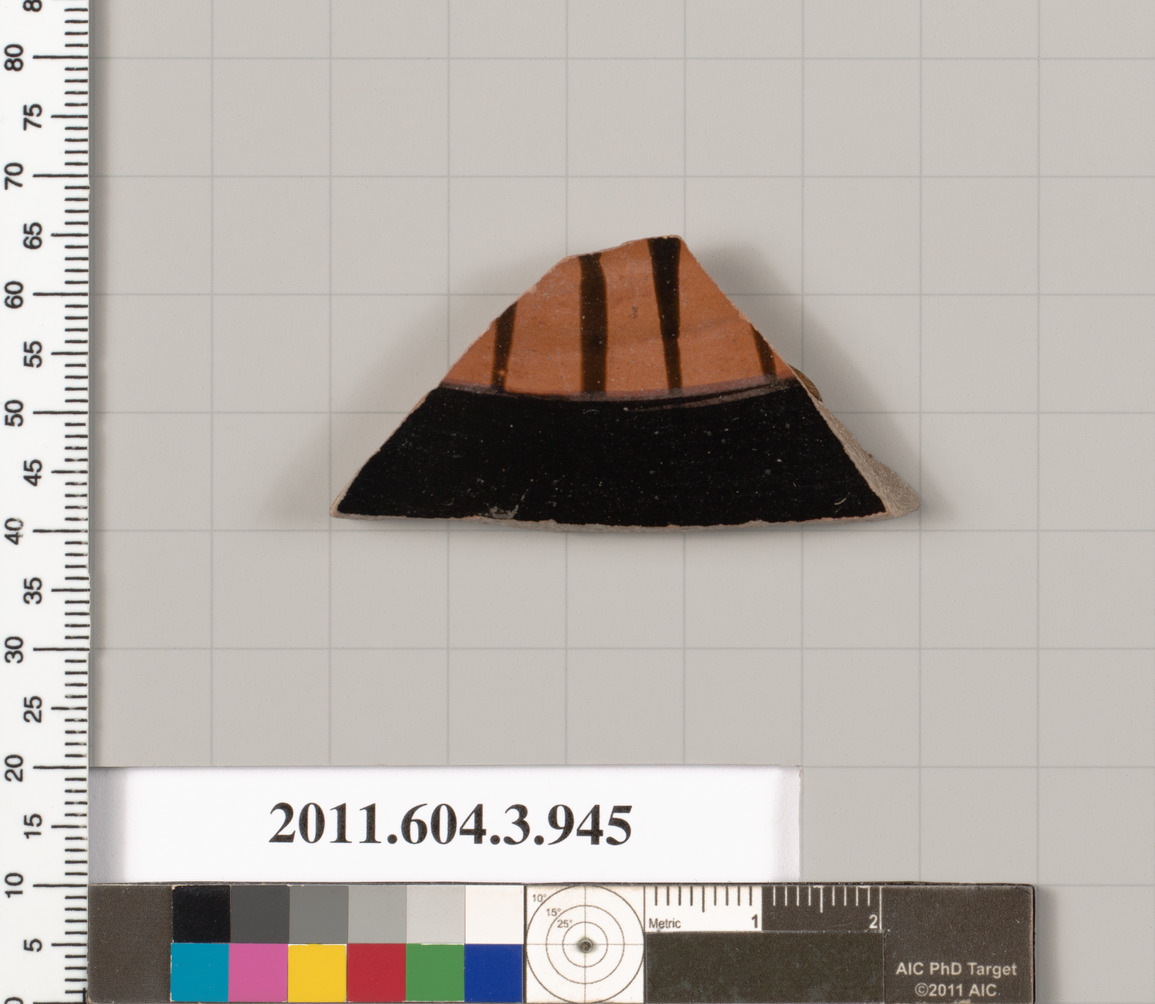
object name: lekanis lid fragment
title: Terracotta fragment of a lekanis lid (covered dish)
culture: greek, attic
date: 600-501 BCE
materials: terracotta